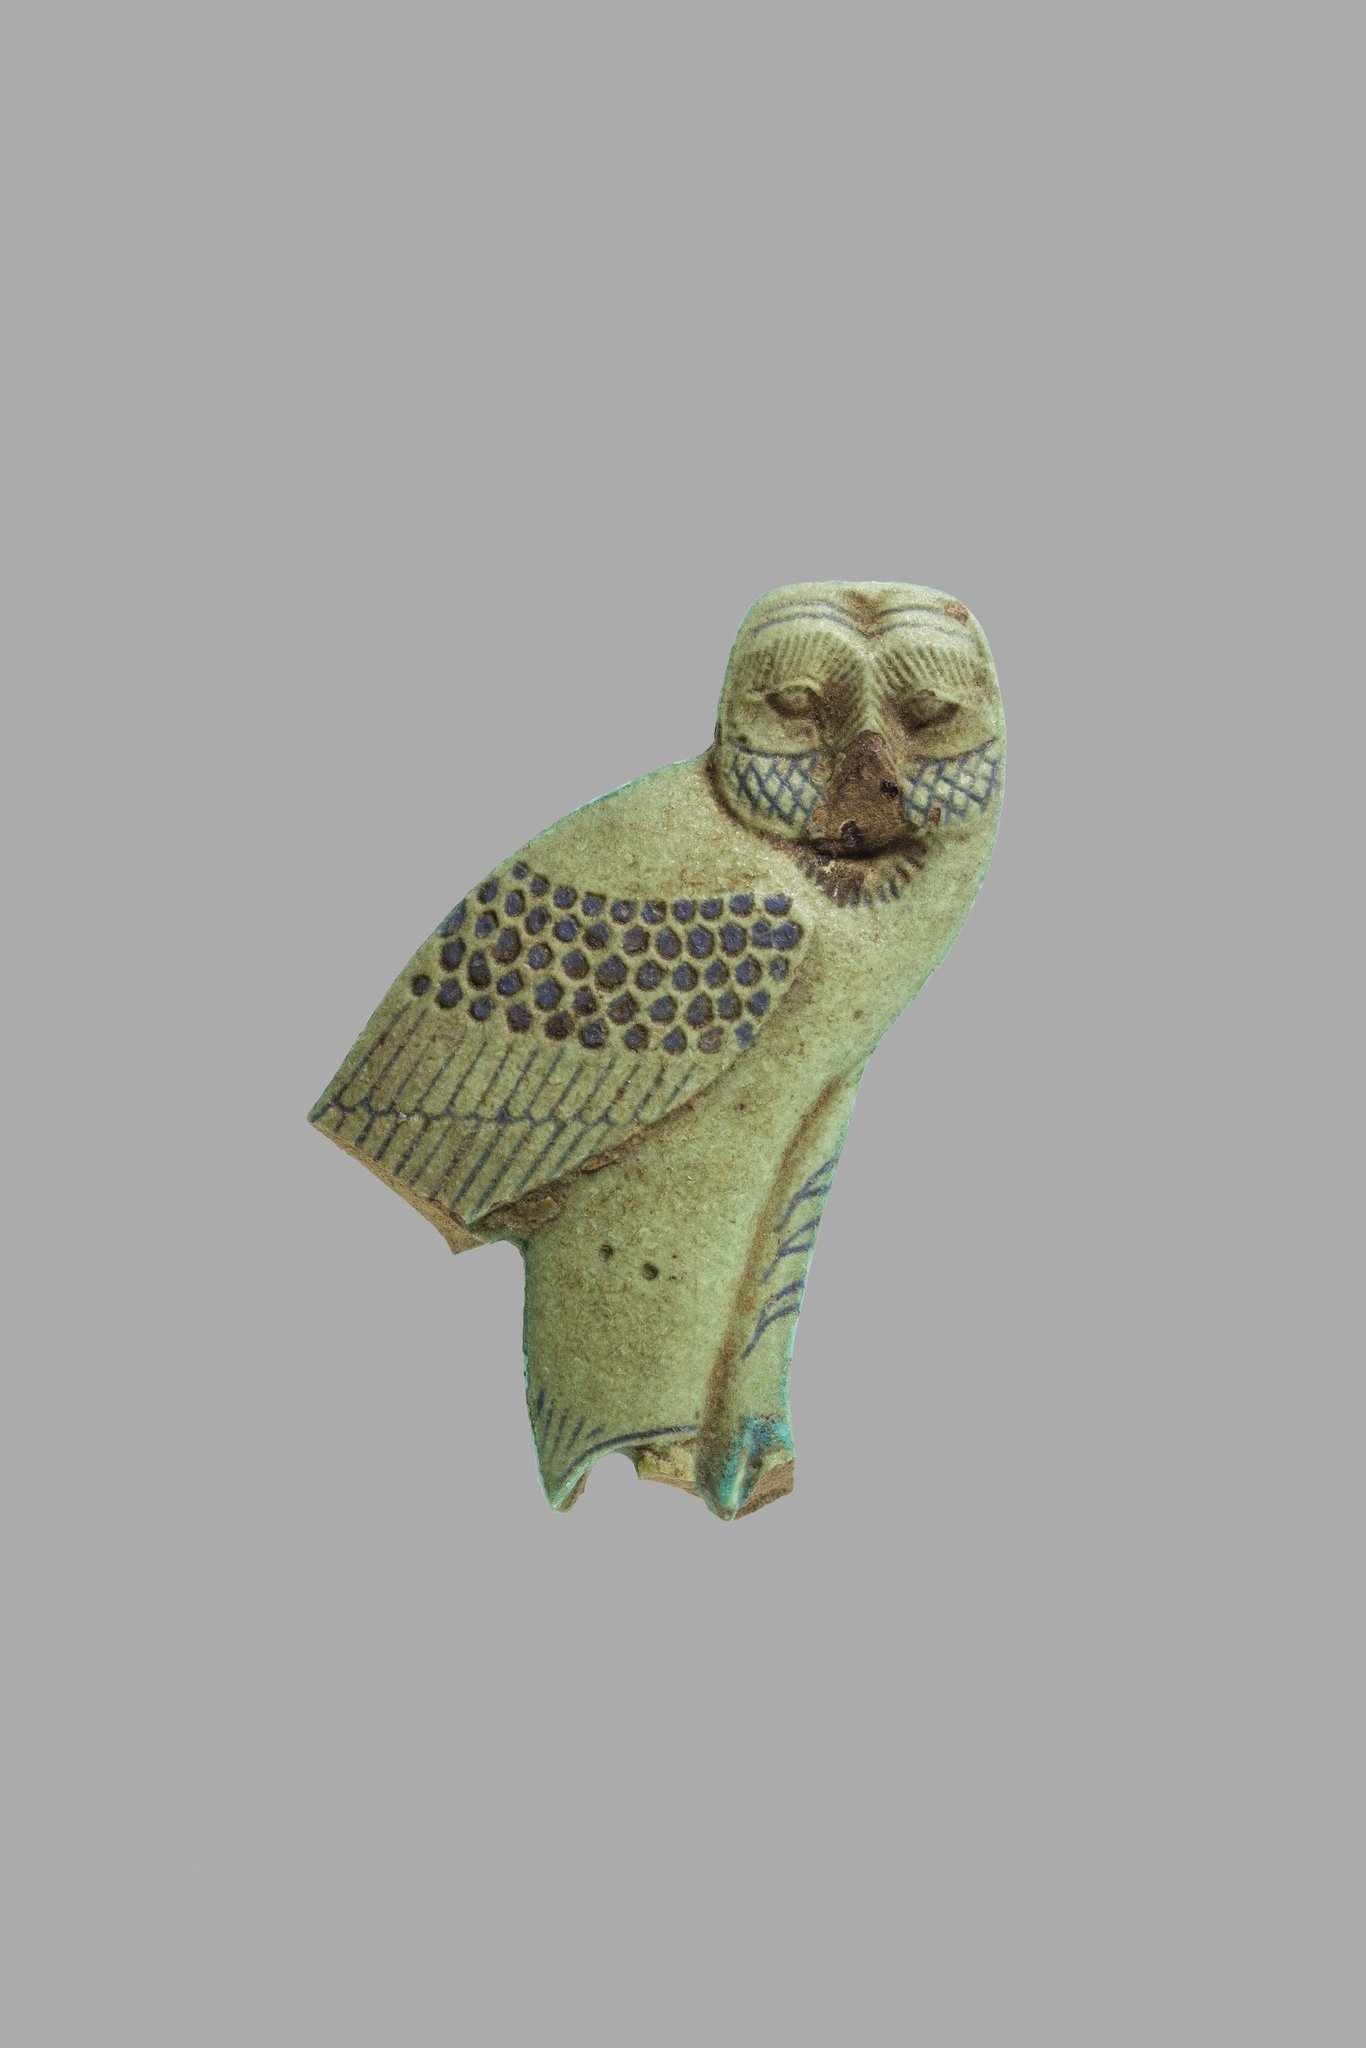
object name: inlay, owl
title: Owl inlay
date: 664-630 BCE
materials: faience, paste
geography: egypt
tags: owls